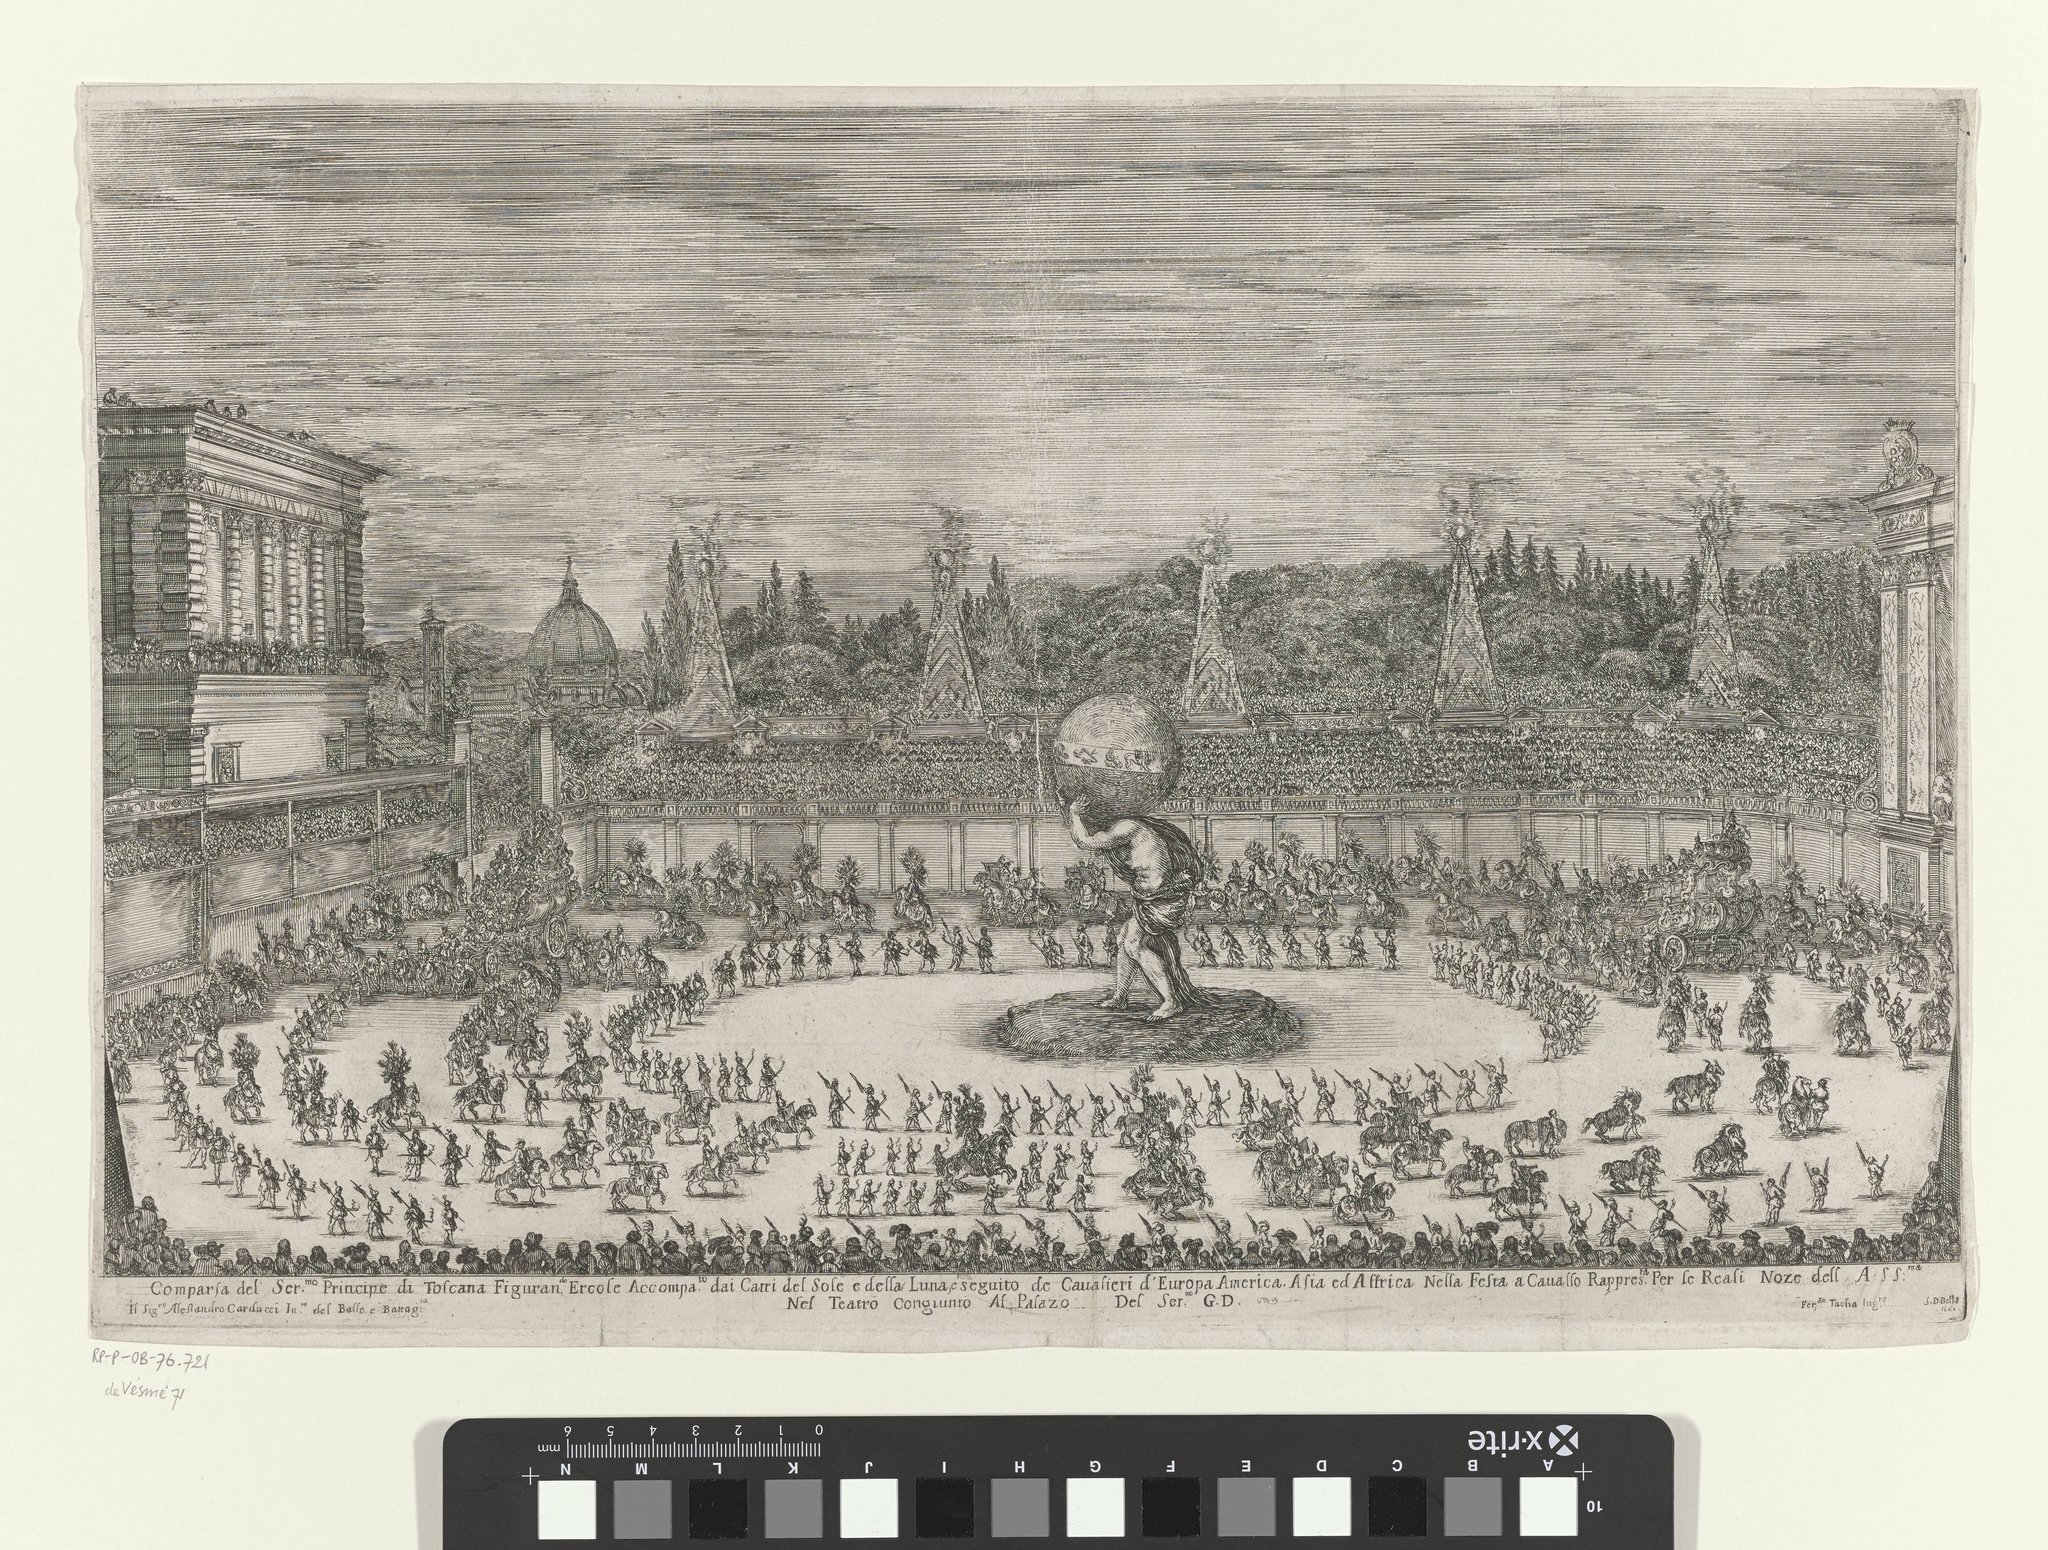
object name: print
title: Il mondo festeggiante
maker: stefano della bella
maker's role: draughtsman, print maker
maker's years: 1610-1664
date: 1661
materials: paper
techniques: etching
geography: italy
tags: riding a horse, ass, or mule; rider, horseman, (story of) hercules (heracles), festivities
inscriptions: collector's mark: Lugt 2228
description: Reeks van 3 prenten met voorstellingen van een carroussel ter ere van het huwelijk van Cosimo III en Marguerite Louise d'Orléans op 1 juli 1661. Prent gebruikt als illustratie in 'Il Mondo festeggiante: balletto a cavallo fatto nel teatro congiunto al palazzo del Sereniss. Gran Duca, per le reali nozze de' Serenissimi Principi Cosimo terzo di Toscana e Margherita Luisa d'Orleans', Florence 1661. Getekende voorstudie wordt bewaard in de Galleria degli Uffizi te Florence (inv. nr. 8068 F).